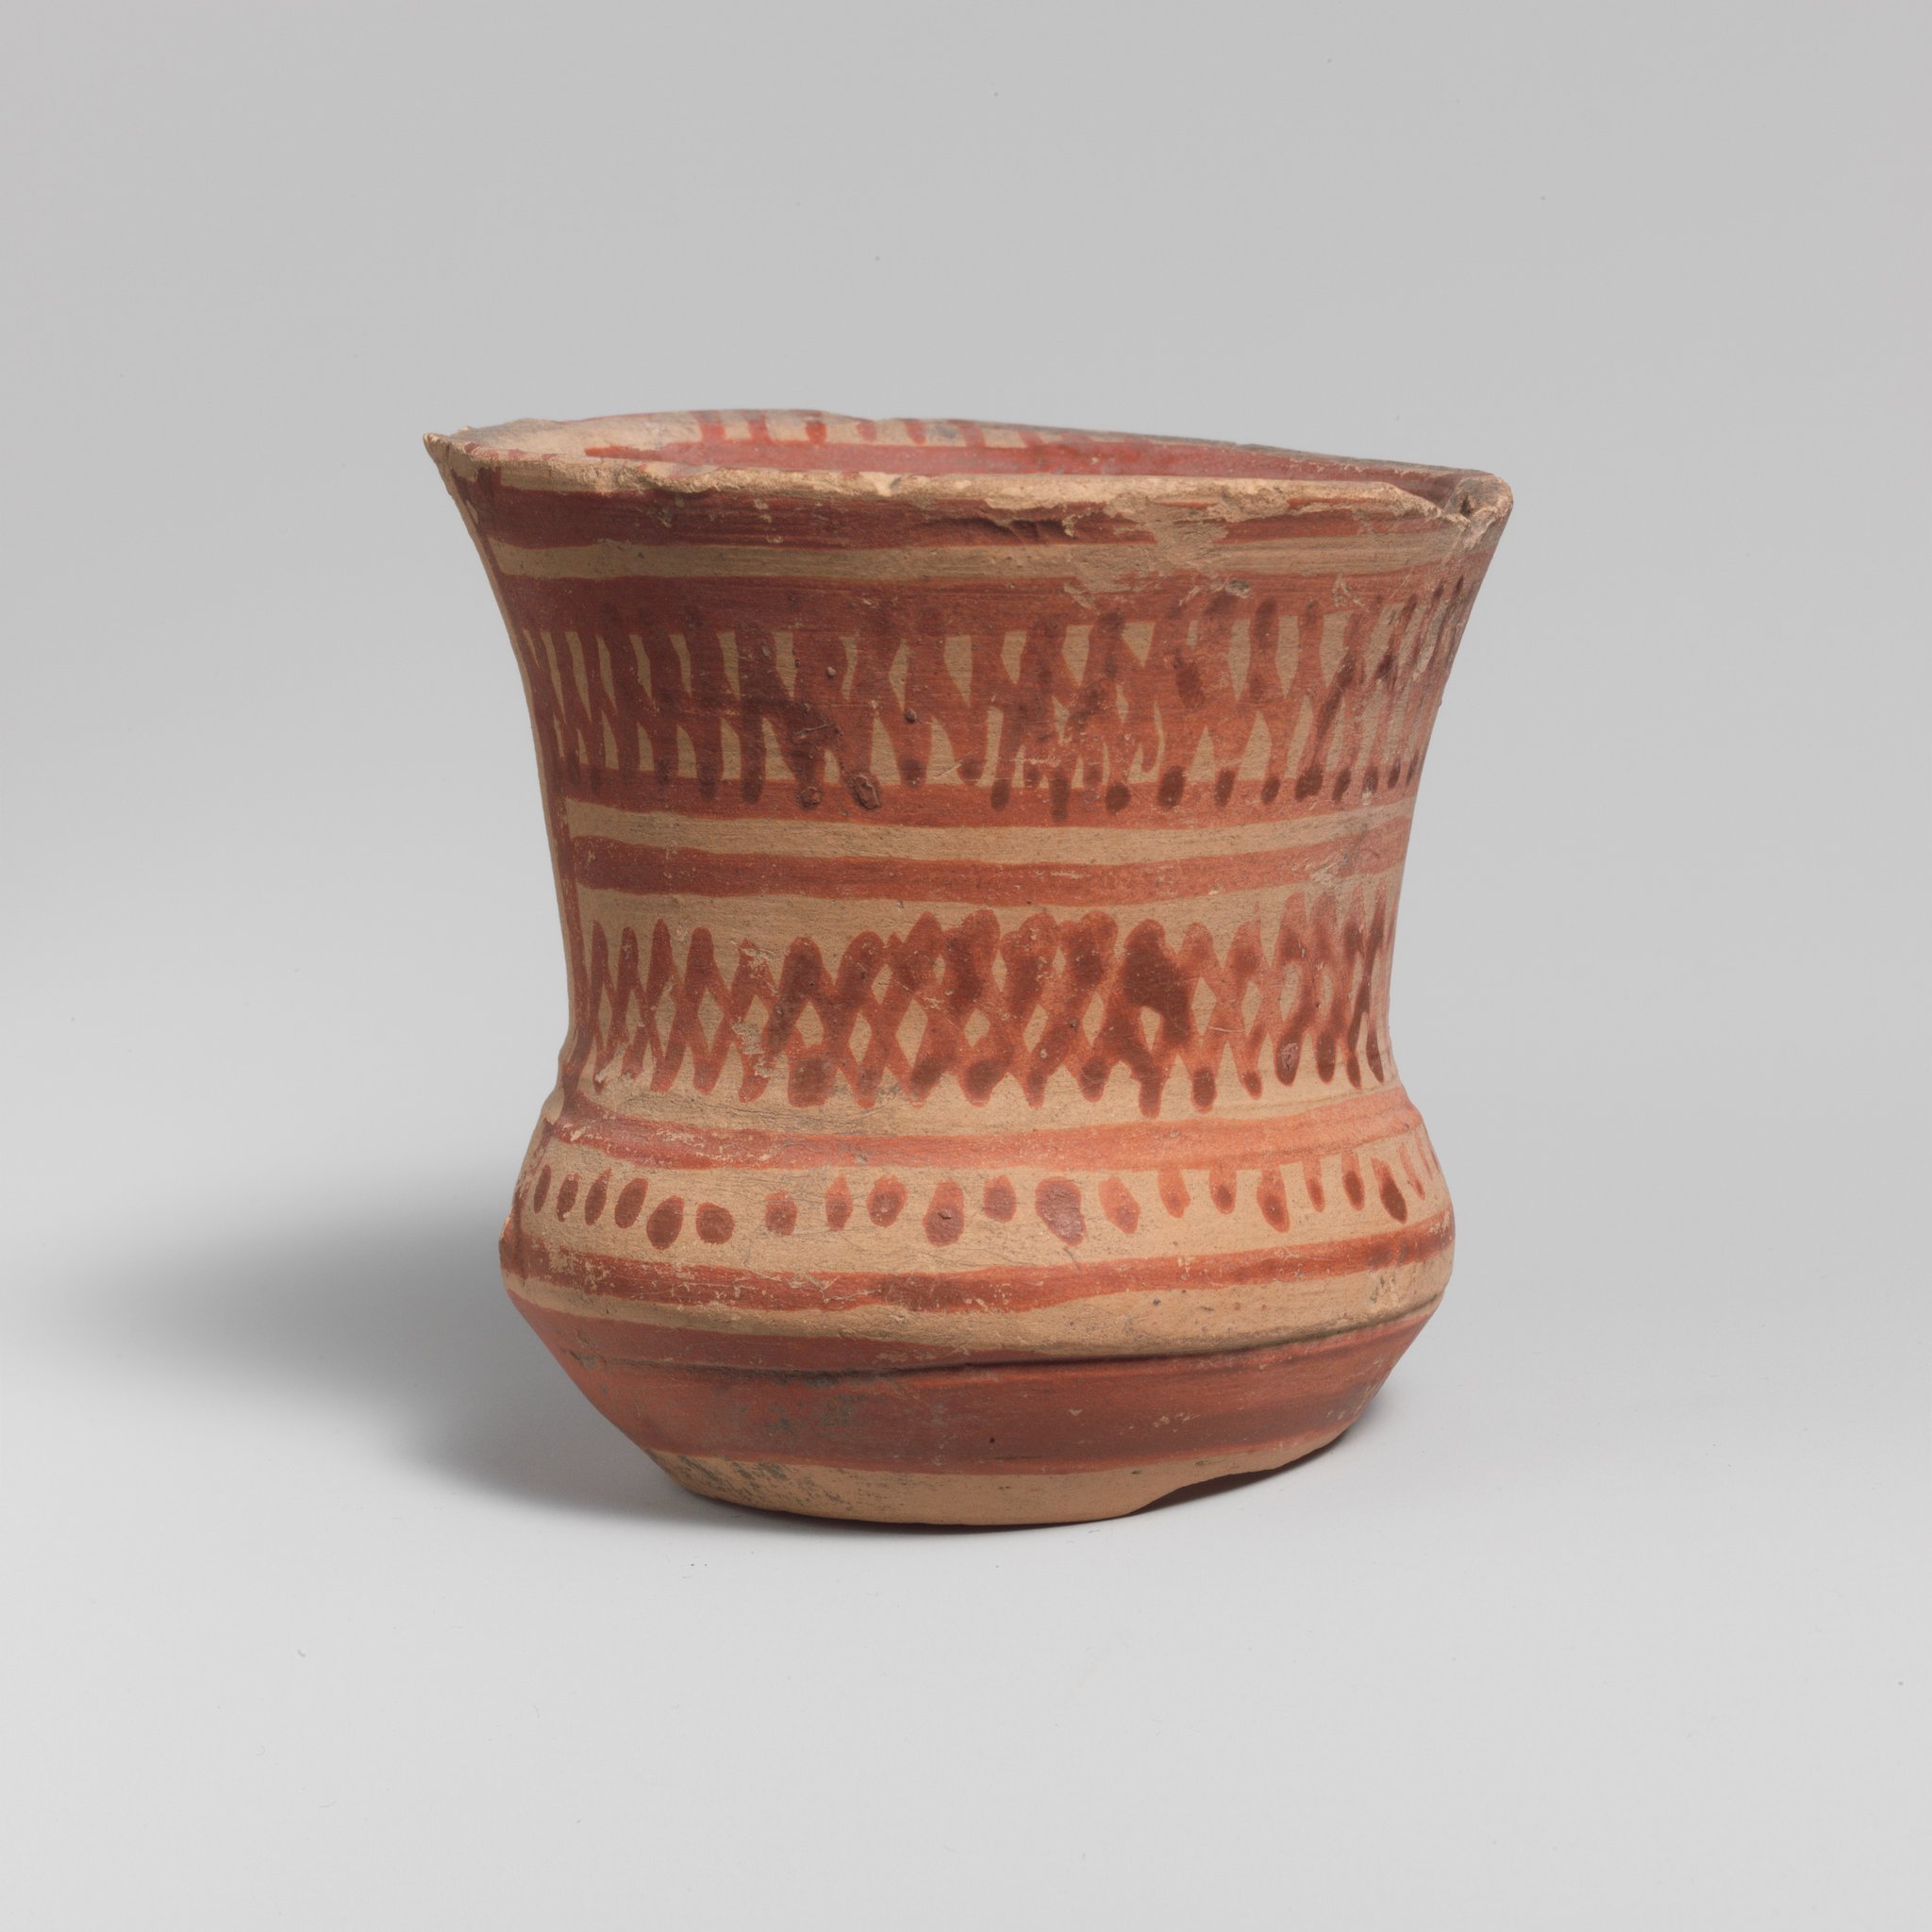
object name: tankard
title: Terracotta tankard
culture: greek, attic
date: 734-701 BCE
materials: terracotta